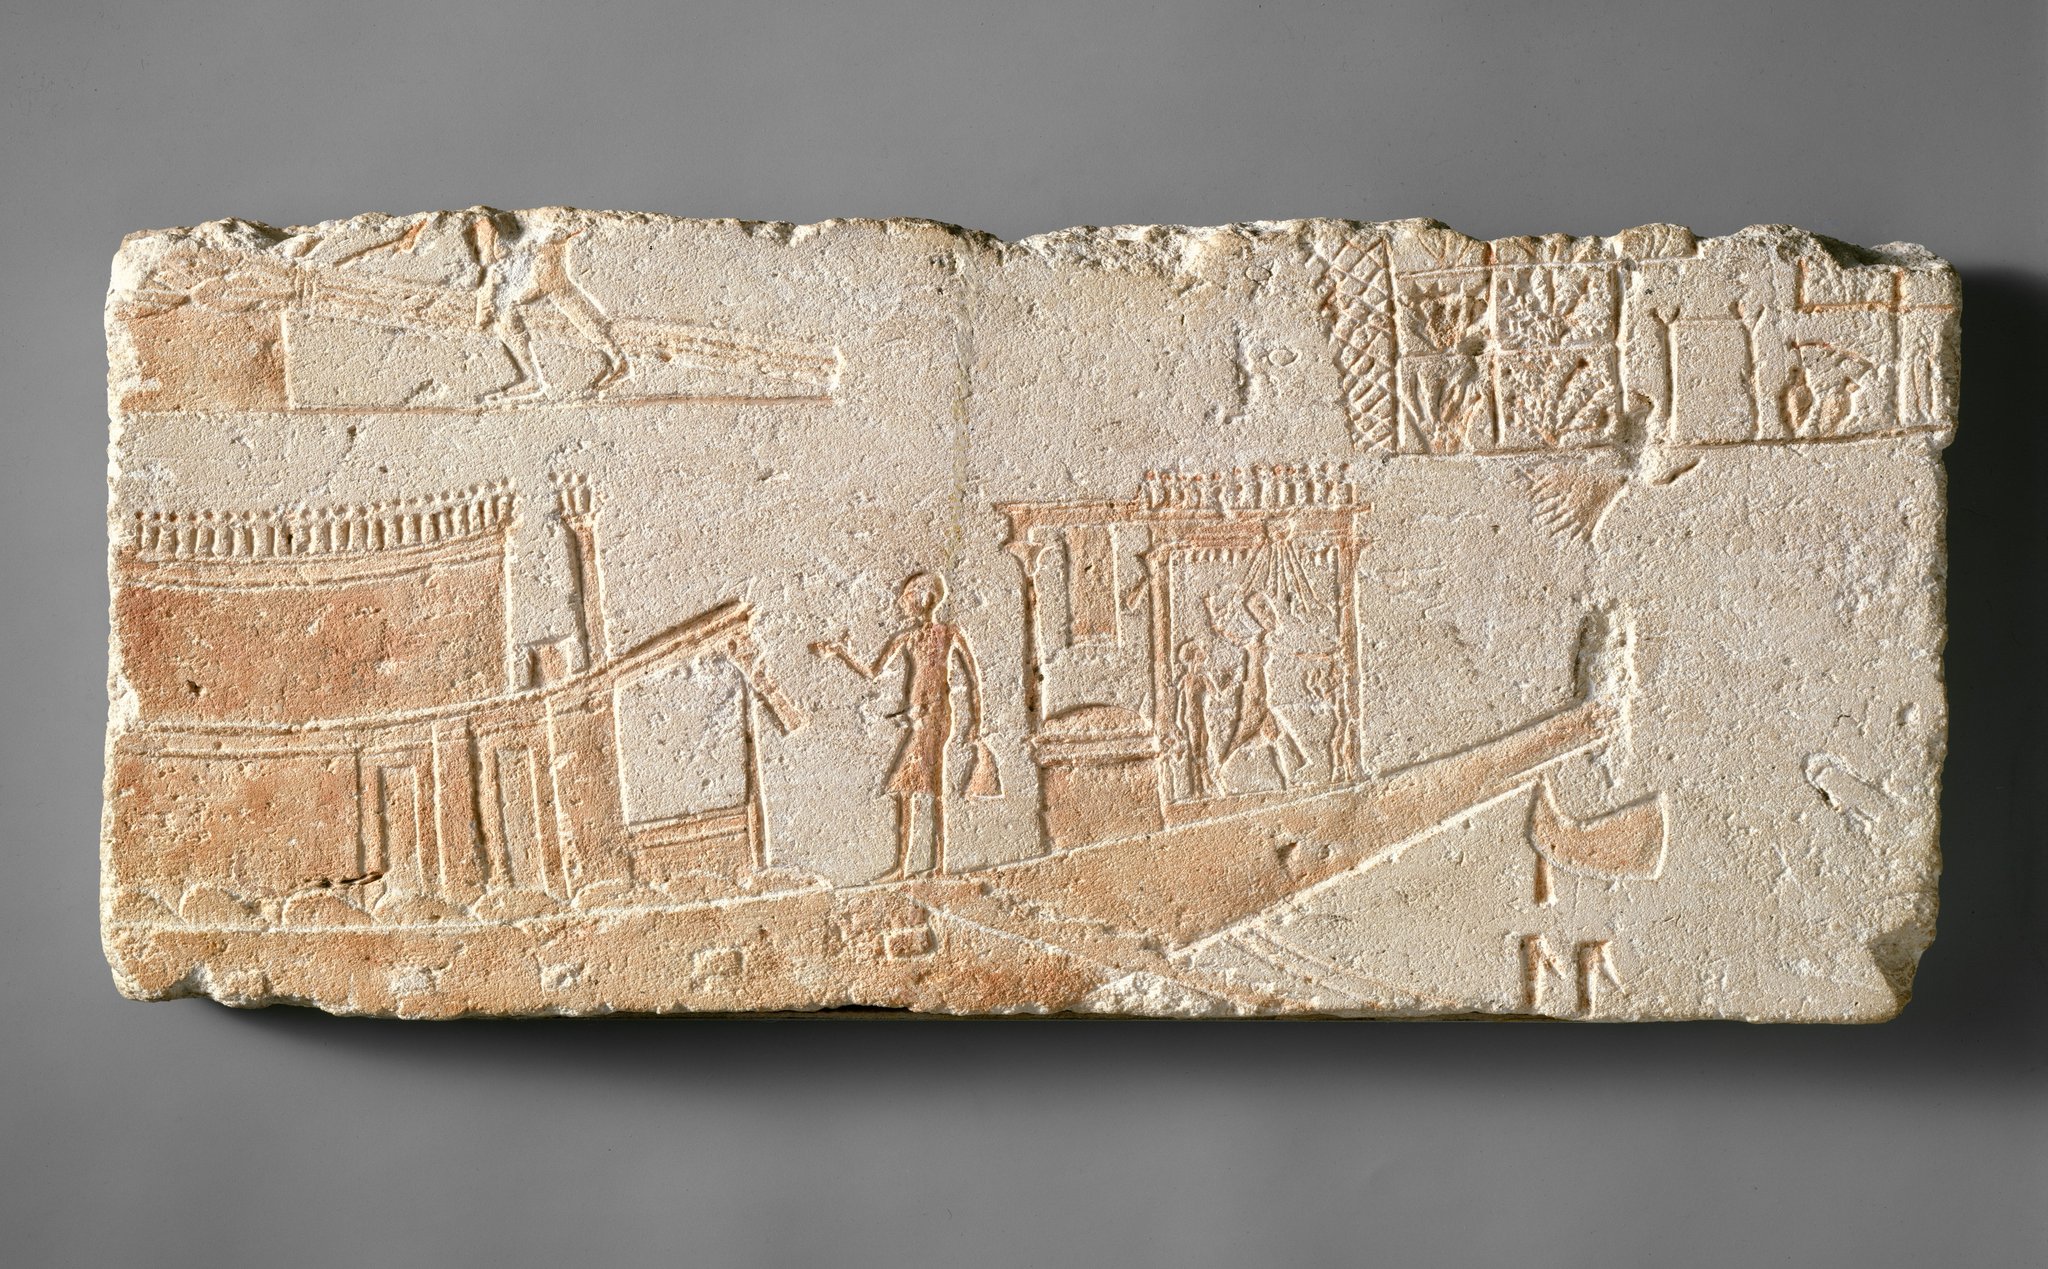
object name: talatat, royal barge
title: Royal Barge at its Mooring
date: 1353-1336 BCE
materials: limestone, paint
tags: men,boats